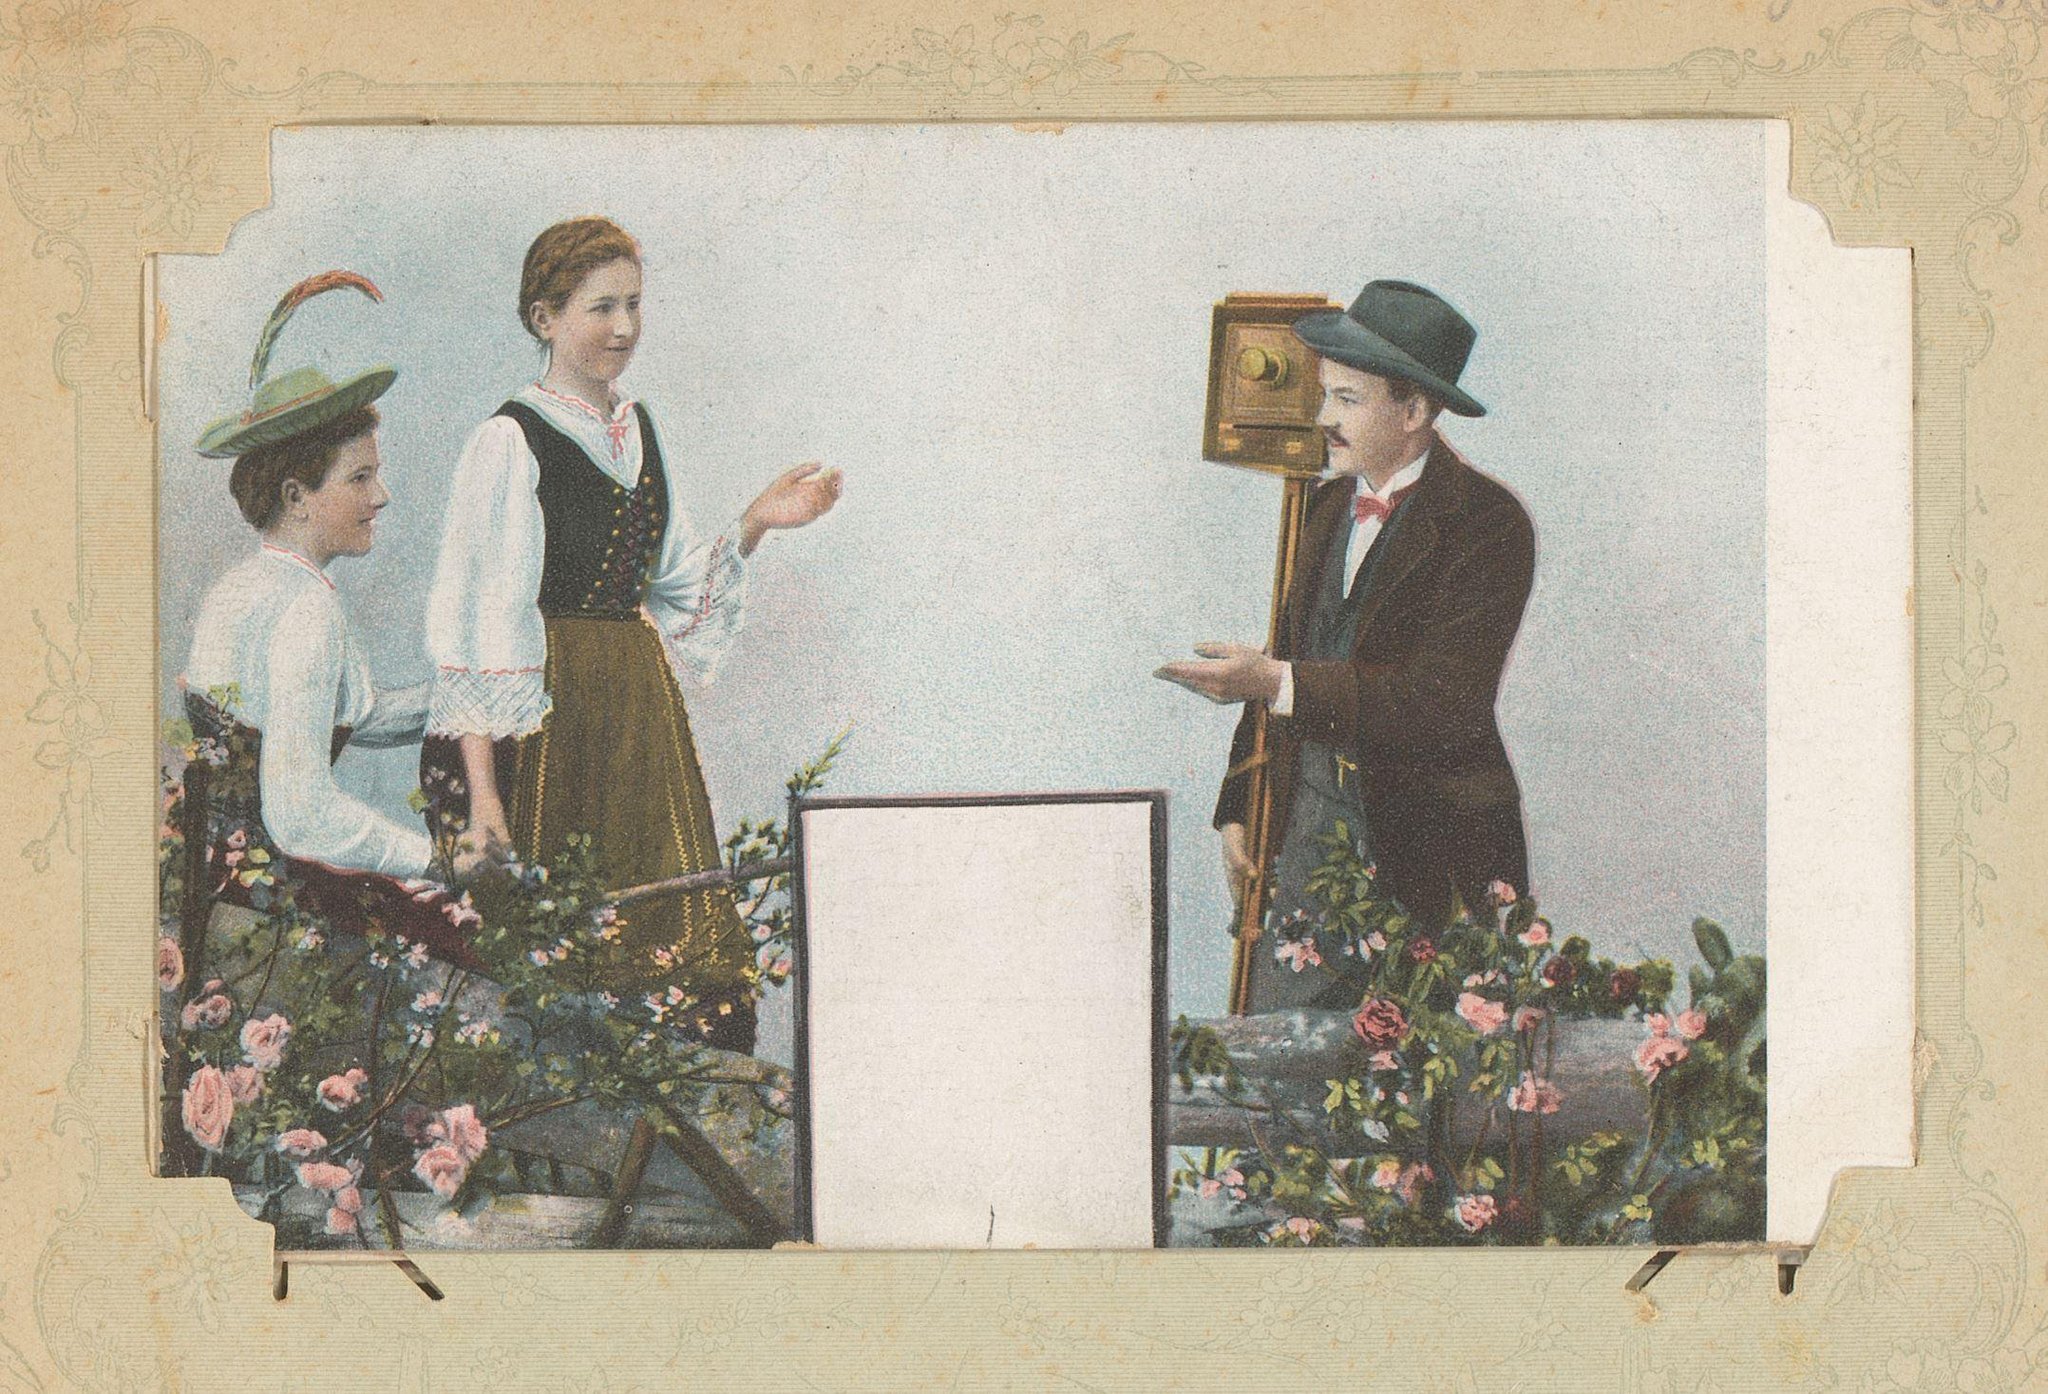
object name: photomechanical print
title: Twee vrouwen en een man met camera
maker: Anonymous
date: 1900-1950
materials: cardboard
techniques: four-color autotype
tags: flowers, adult woman, photography, adult man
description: Deze prent maakt deel uit van een album.